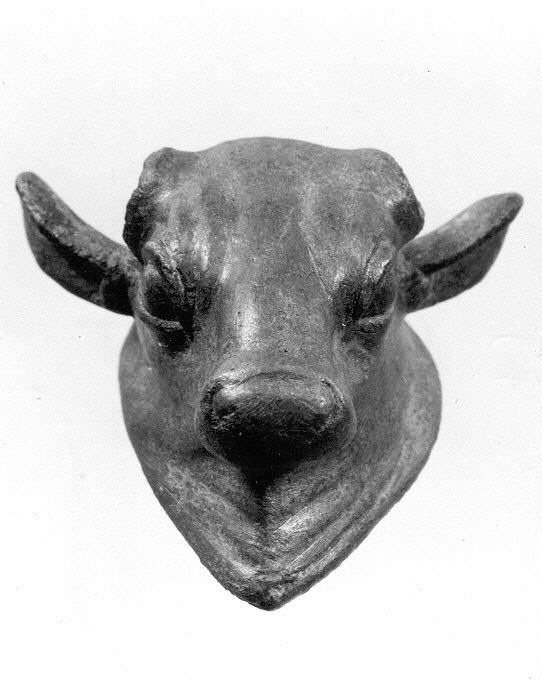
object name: cauldron attachment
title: Cauldron attachment: bull's head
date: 700-601 BCE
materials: bronze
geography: greece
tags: bulls